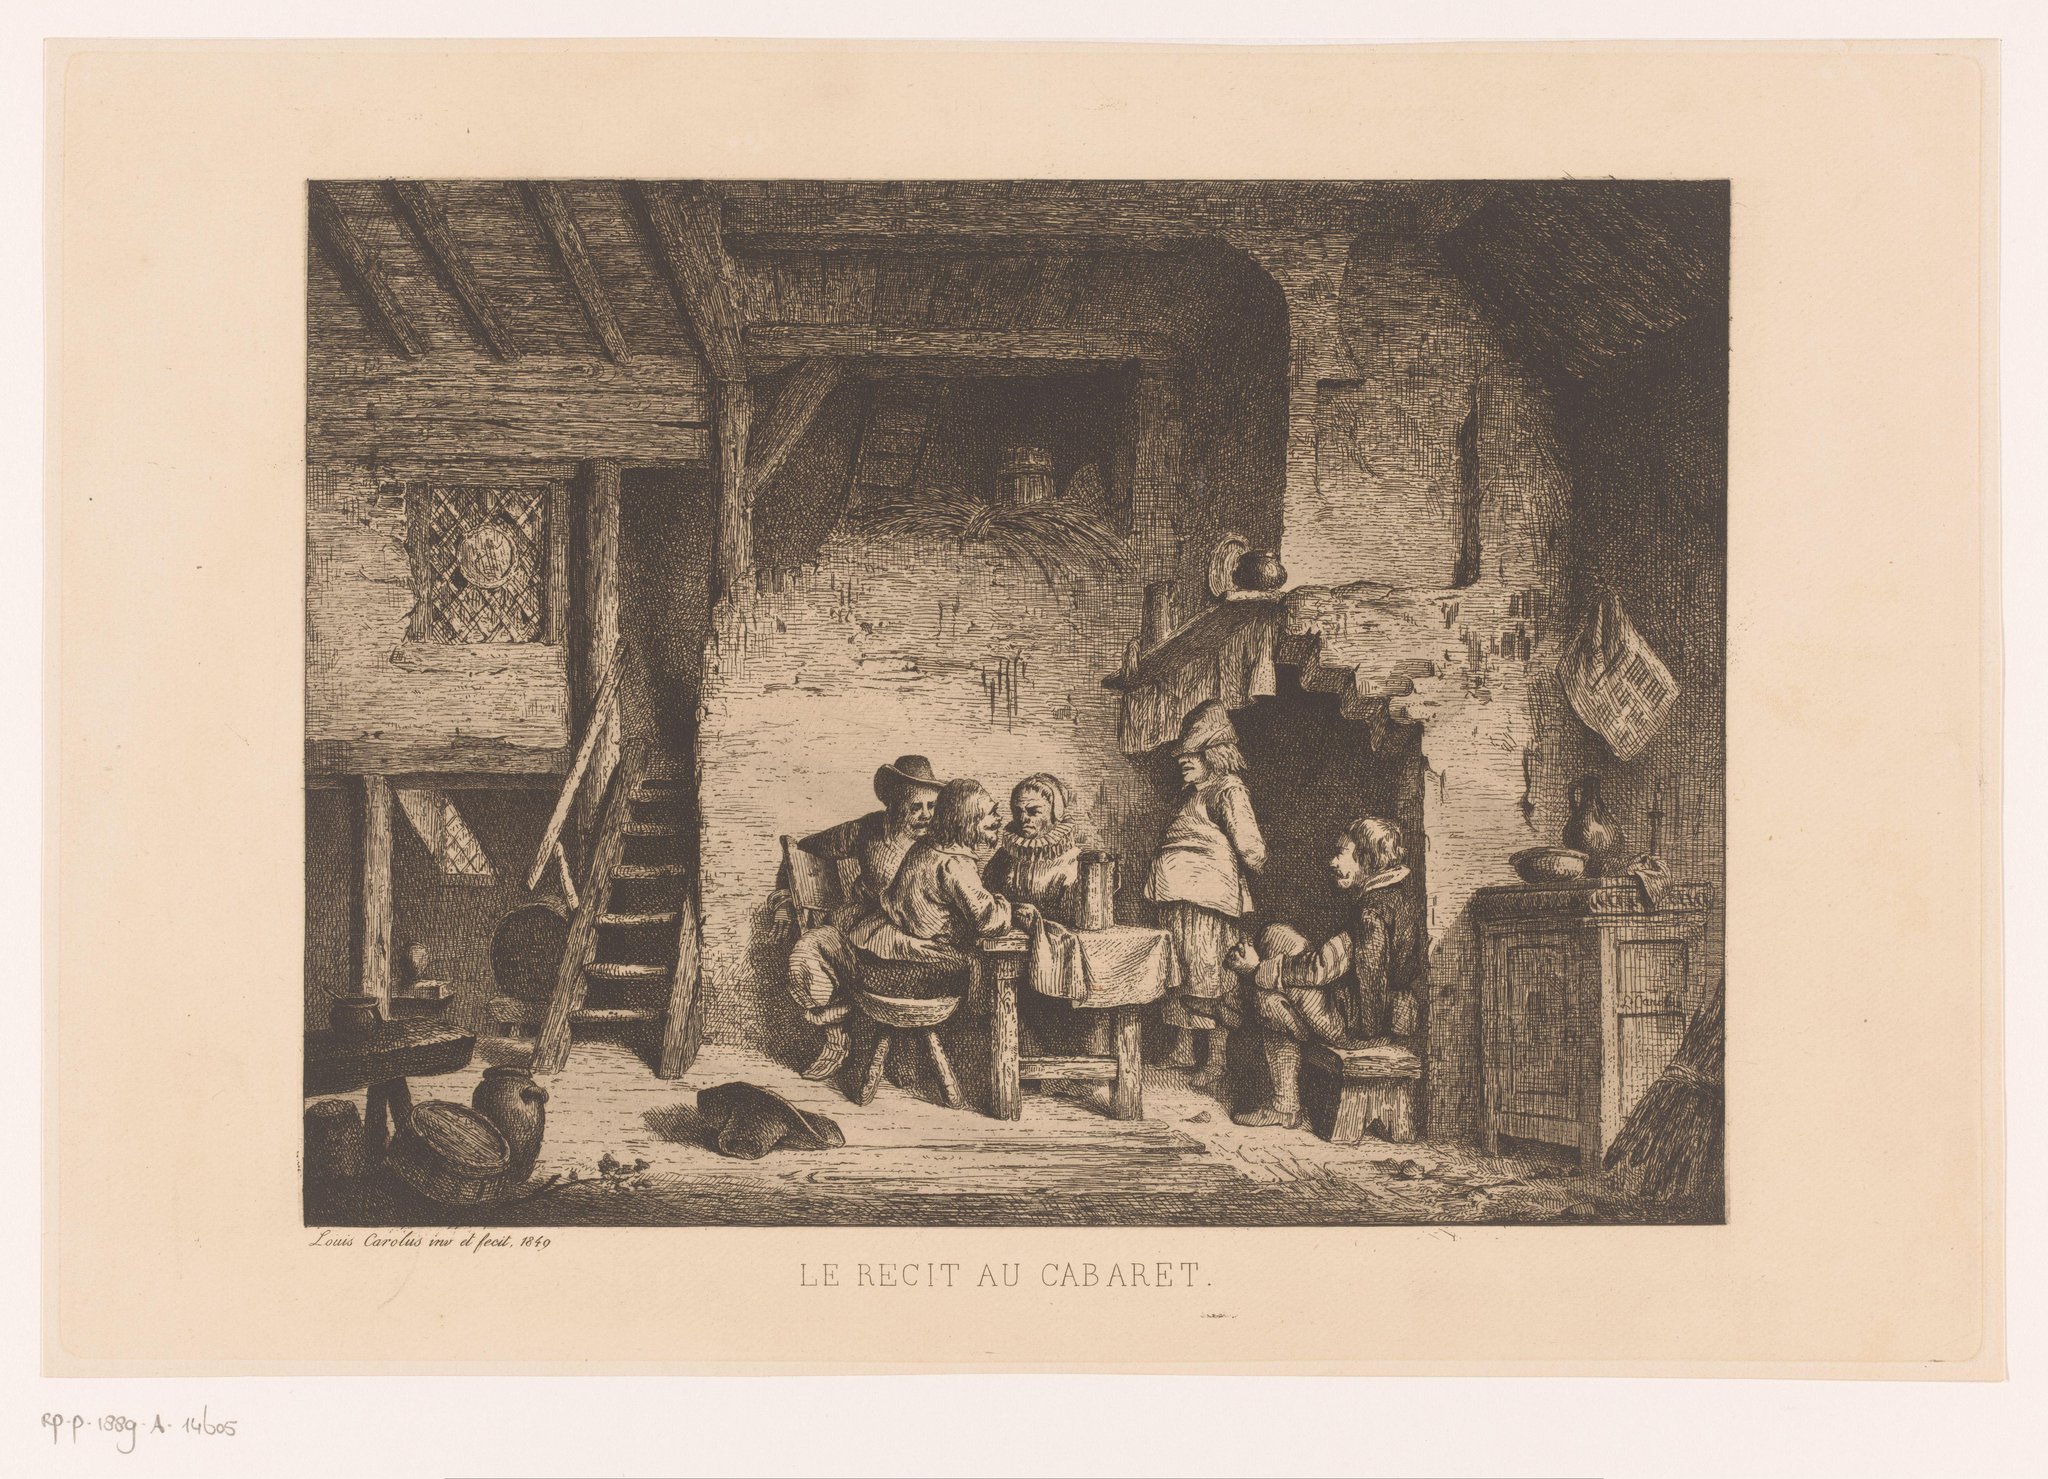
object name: print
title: Gezelschap in zestiende-eeuwse kleding in een kroeg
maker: louis antoine carolus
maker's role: print maker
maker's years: 1814-1865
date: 1849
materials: paper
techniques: drypoint, etching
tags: inn, coffee-house, public house, etc.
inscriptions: collector's mark: Lugt 2228